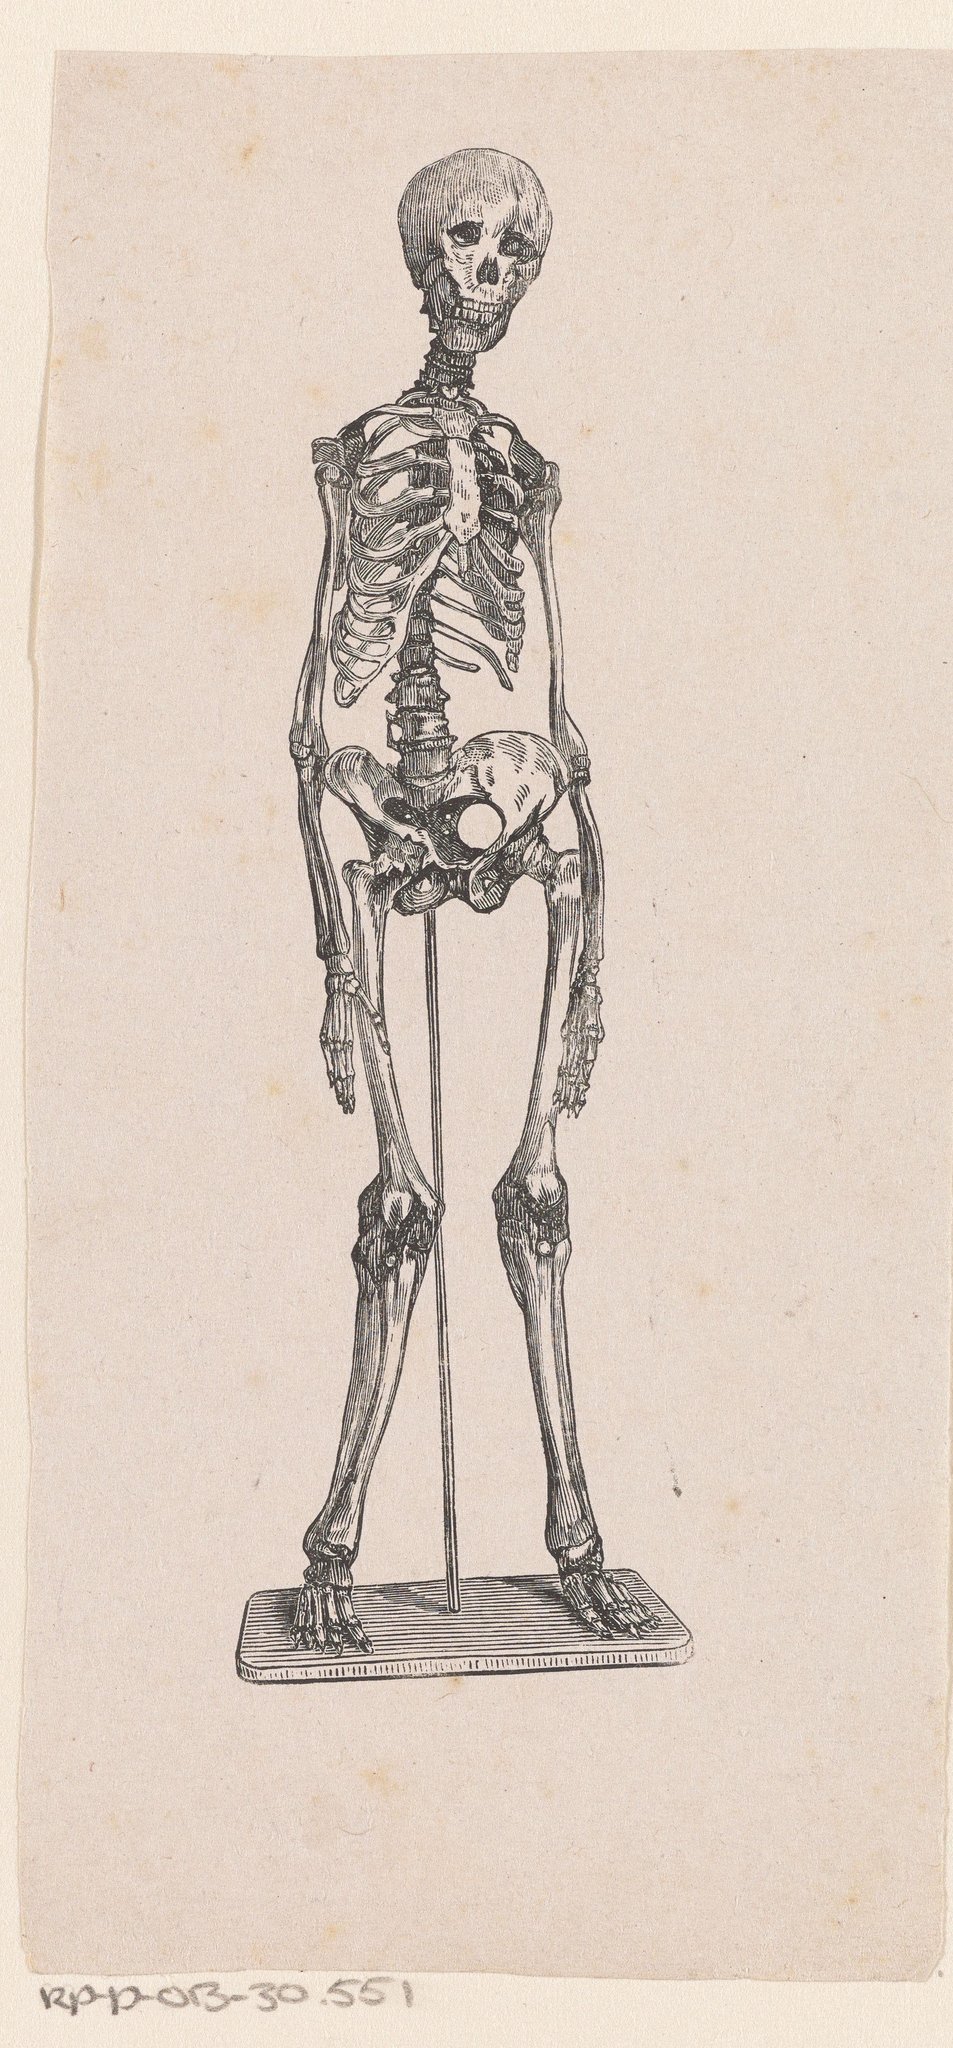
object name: print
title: Menselijk skelet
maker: isaac weissenbruch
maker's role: print maker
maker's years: 1826-1912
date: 1836-1912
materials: paper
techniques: engraving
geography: netherlands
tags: (human) skeleton